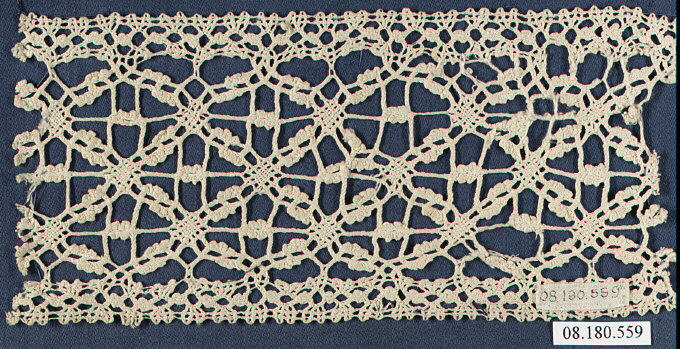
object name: fragment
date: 1601-1700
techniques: lace